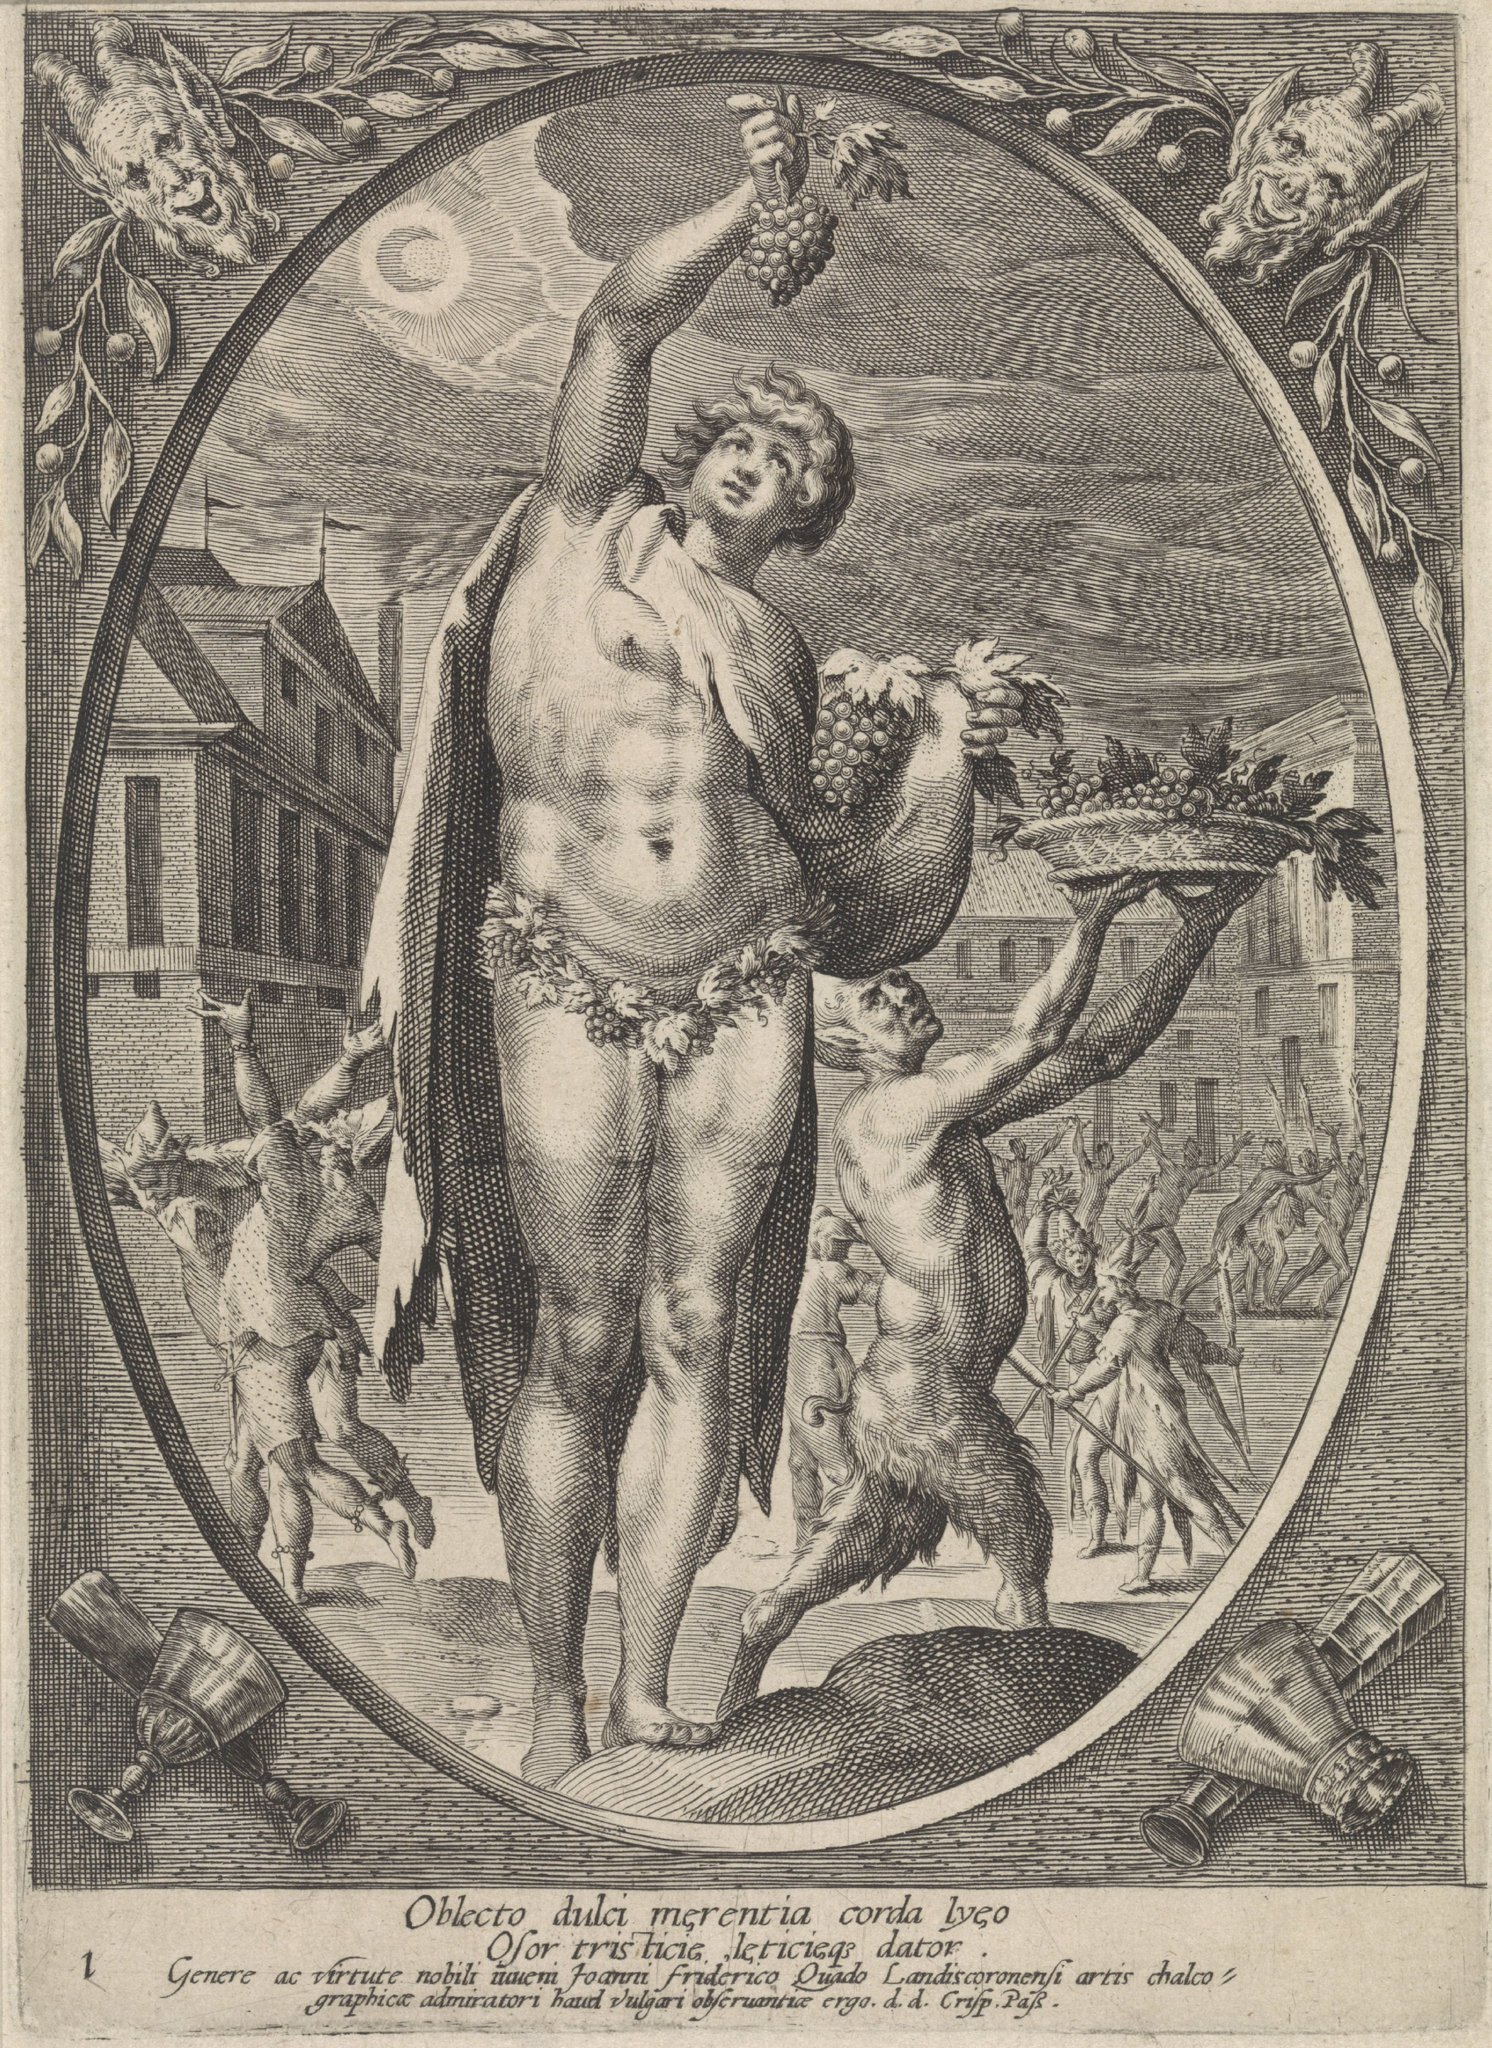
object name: print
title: Bacchus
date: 1574-1637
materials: paper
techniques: engraving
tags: (story of) bacchus (dionysus), liber, group dancing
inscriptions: collector's mark: Lugt 2228, collector's mark: Lugt 2760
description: Bacchus houdt een druiventros boven zijn hoofd. Hij wordt vergezeld door een sater met een fruitmand. Op de achtergrond een dansend gezelschap. In de marge een tweeregelig onderschrift in het Latijn dat verwijst naar het plezier van drinken en een tweeregelig onderschrift met een opdracht in het Latijn. Eerste prent uit een serie van drie met Bacchus, Venus en Ceres.